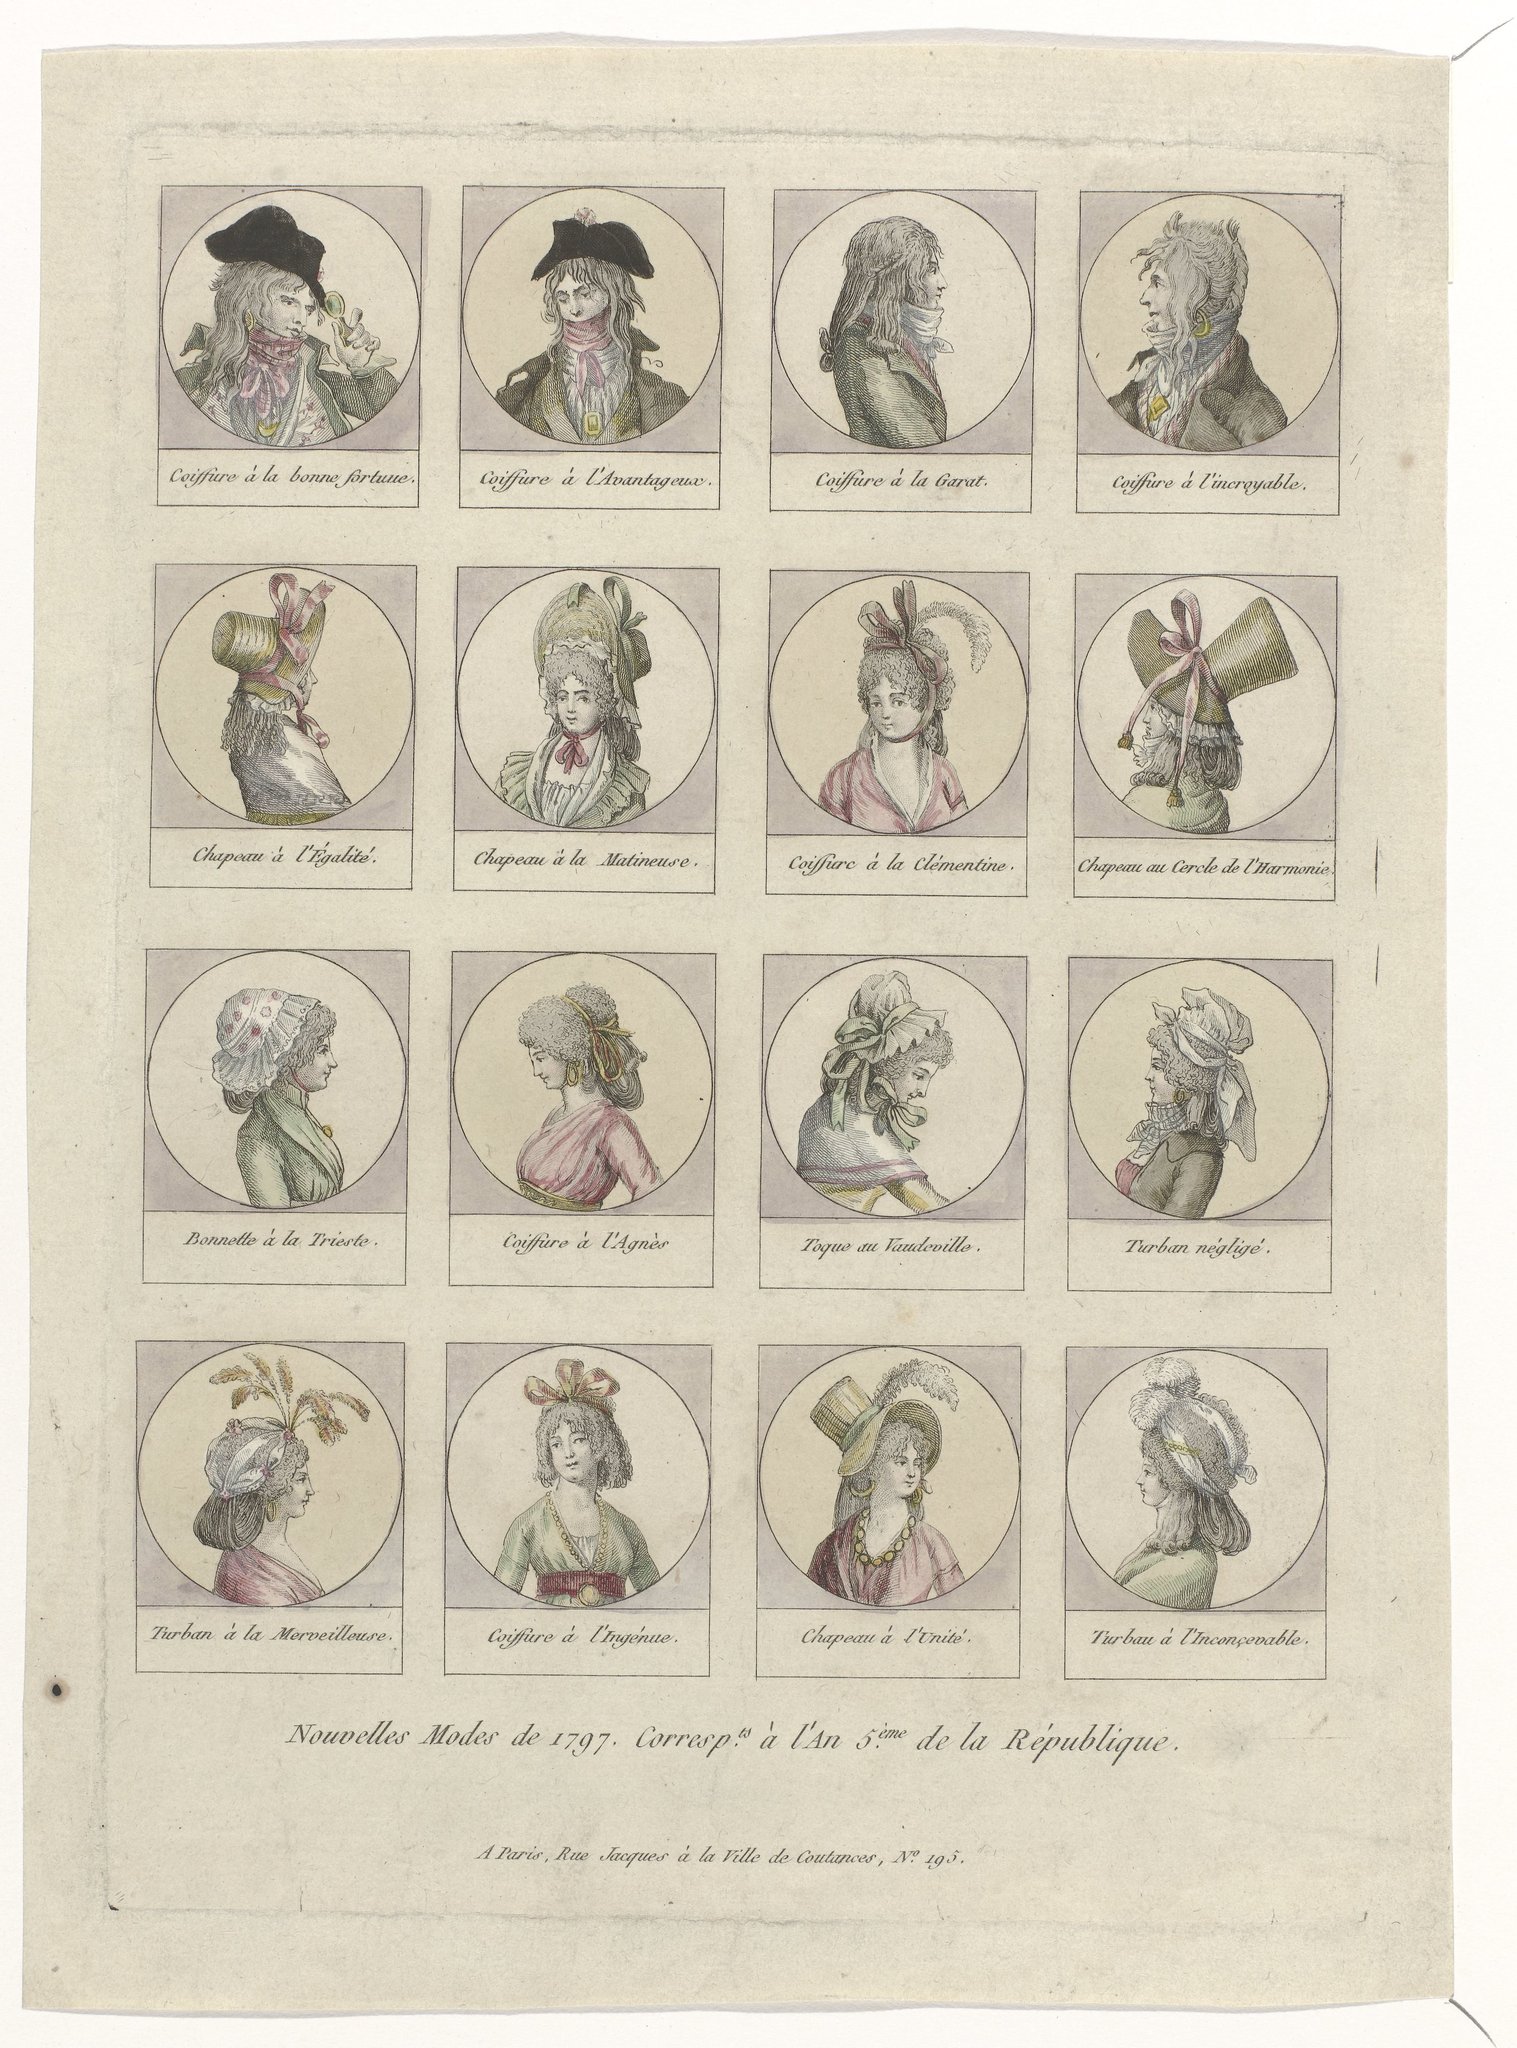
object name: fashion print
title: Gallerie des Modes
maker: claude louis desrais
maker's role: draughtsman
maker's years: 1746-1816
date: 1797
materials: paper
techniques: etching, hand coloring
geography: paris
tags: head-gear: toque (+ women's clothes), head-gear: turban (+ women's clothes), head-gear: hat (+ men's clothes), styles of hairdress, head-gear (bonnet) (+ women's clothes), fashion plates, head-gear: hat (+ women's clothes)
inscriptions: title: ‘Nouvelles Modes de 1797. Corresp..à l'An 5ème de la République’, title: ‘Coiffure à la bonne fortune; Coiffure à l'Avantageux; Coiffure à la Garat; Coiffure à l'incroyable. Chapeau à l'Égalité; Chapeau à la Matineuse; Coiffure à la Clementine; Chapeau au Cercle de l'Harmonie. Bonnette à la Trieste; Coiffure à l'Agnès; Toque au Vaudeville; Turban négligé. Turban à la merveilleuse; Coiffure à l'Ingenue; Chapeau à l'Unité; Turban à l'Inconcevable’, address: ‘A Paris, Rue Jacques 1a la Ville de Constances, No. 195’